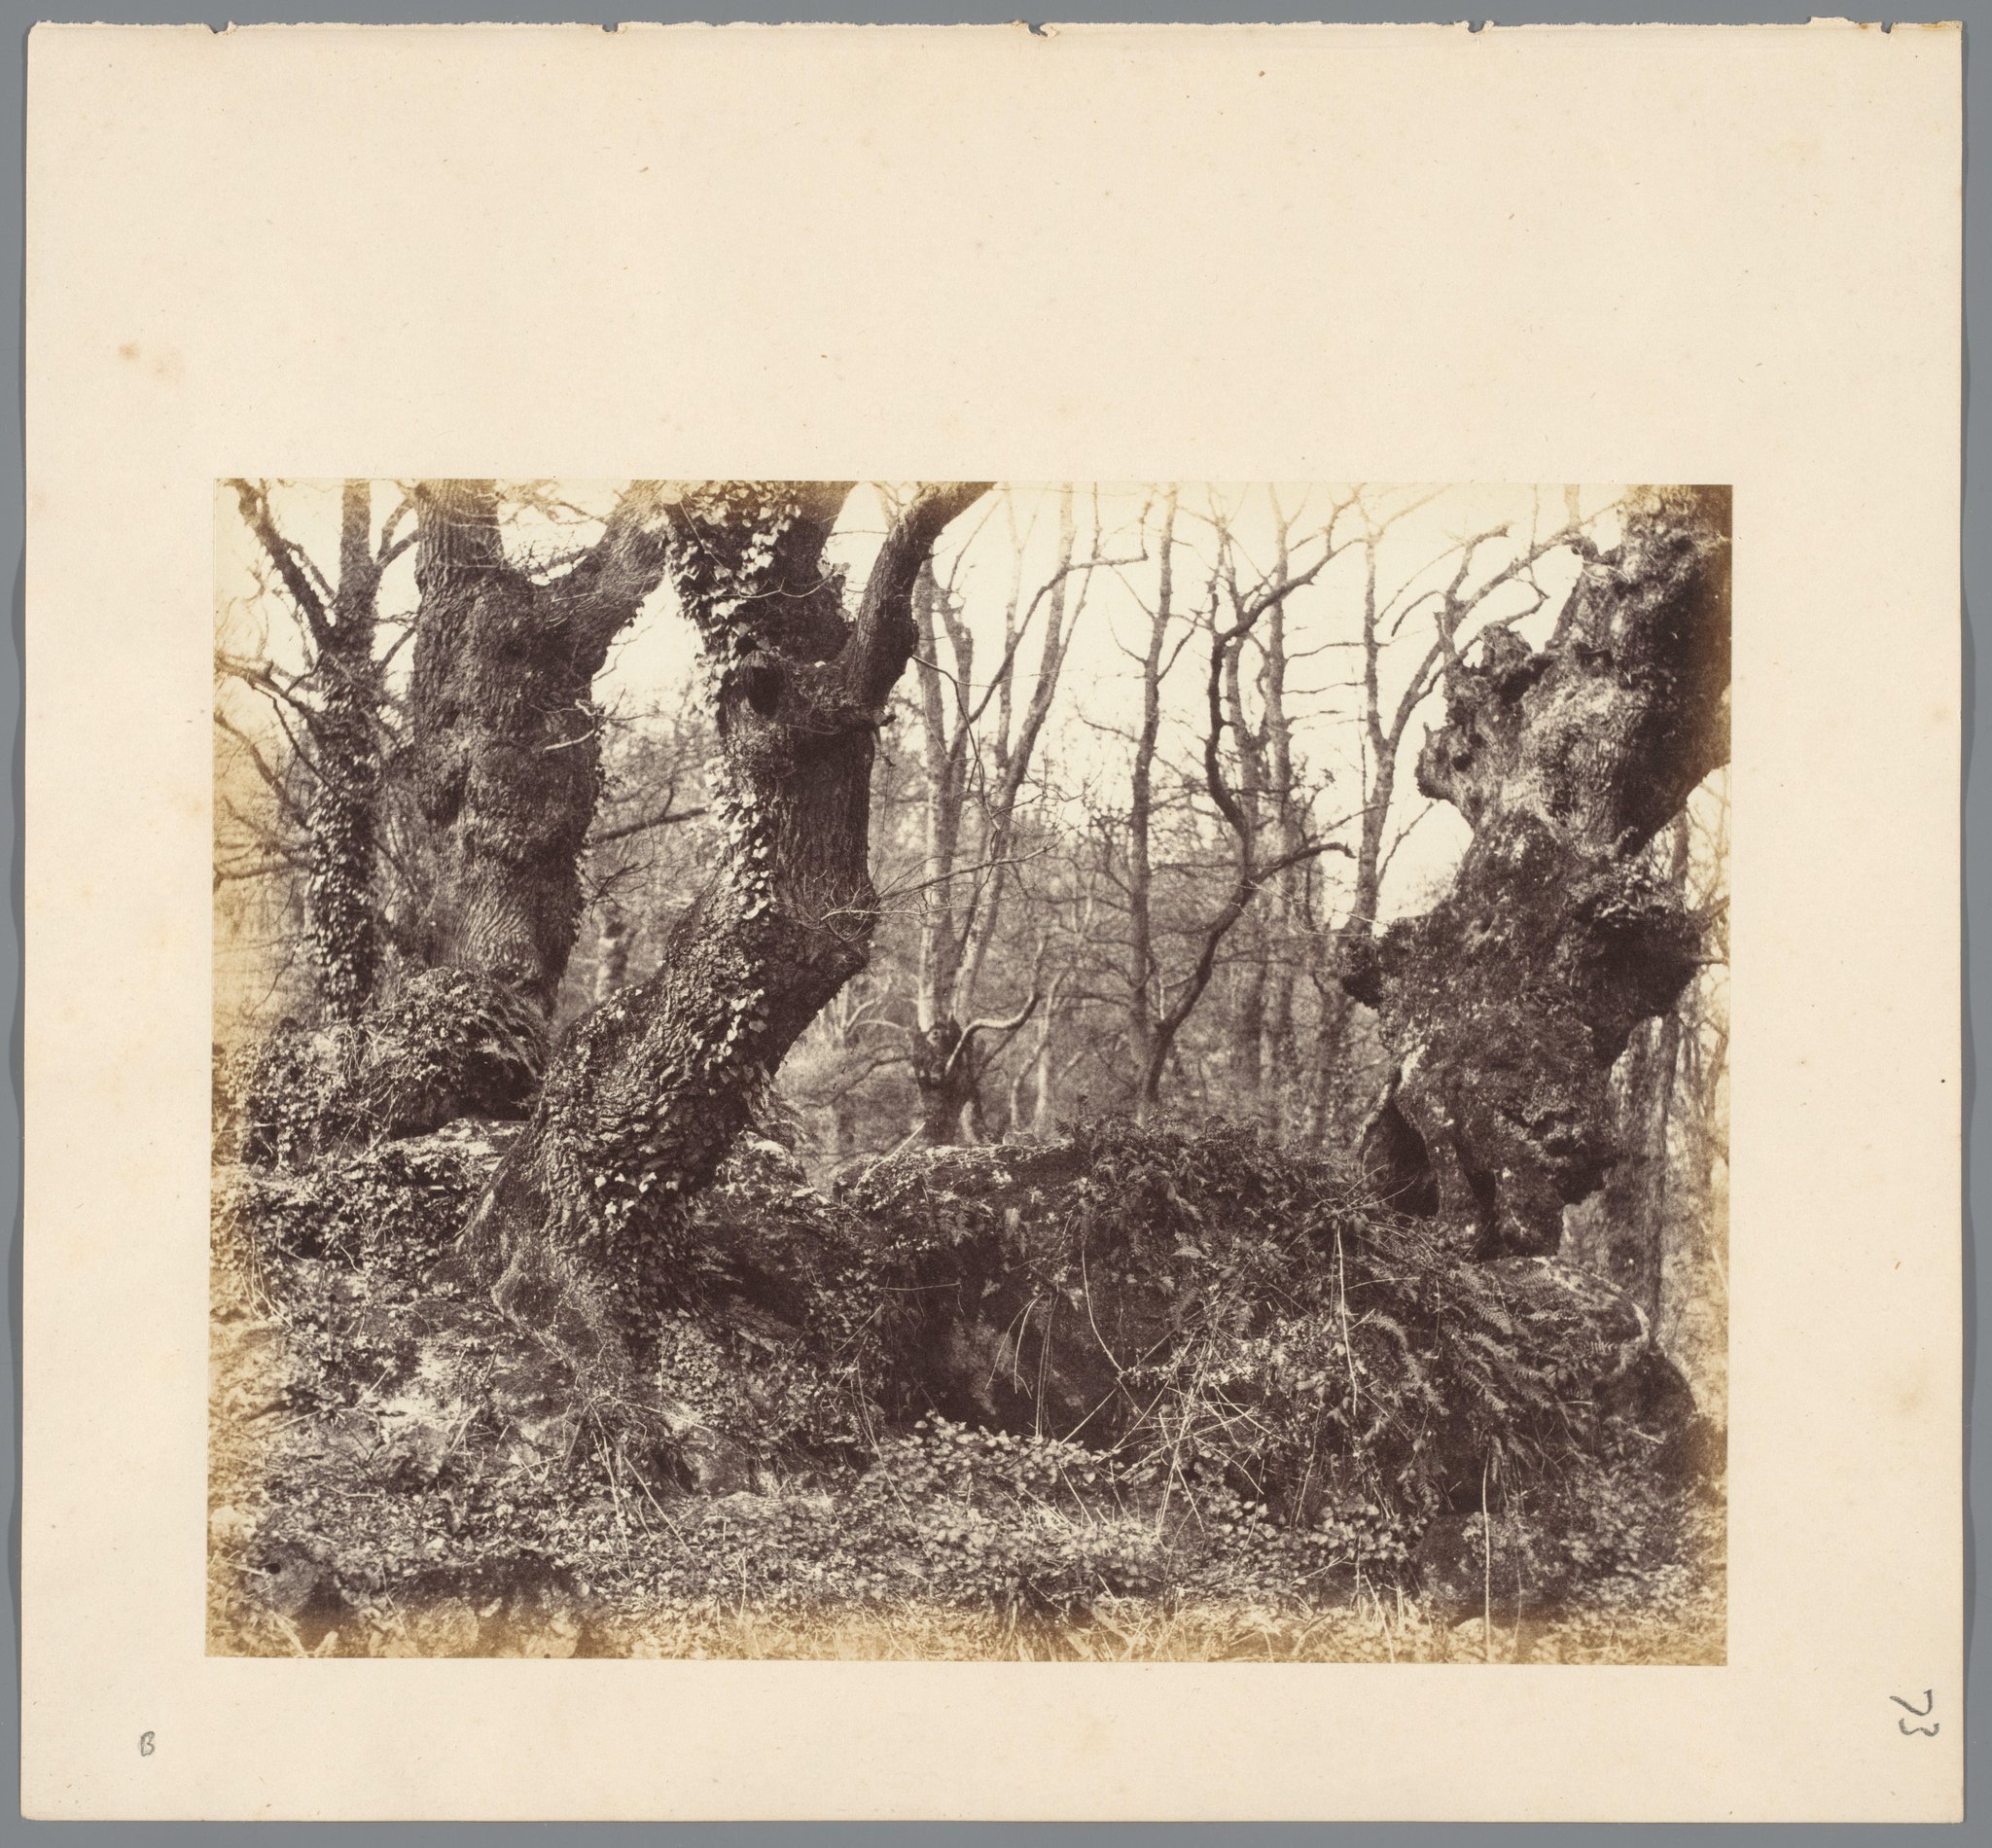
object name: photograph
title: Boomstudie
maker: hugh owen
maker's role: fotograaf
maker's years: 1808-1897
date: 1848-1851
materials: paper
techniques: albumen print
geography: england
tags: trees, great britain